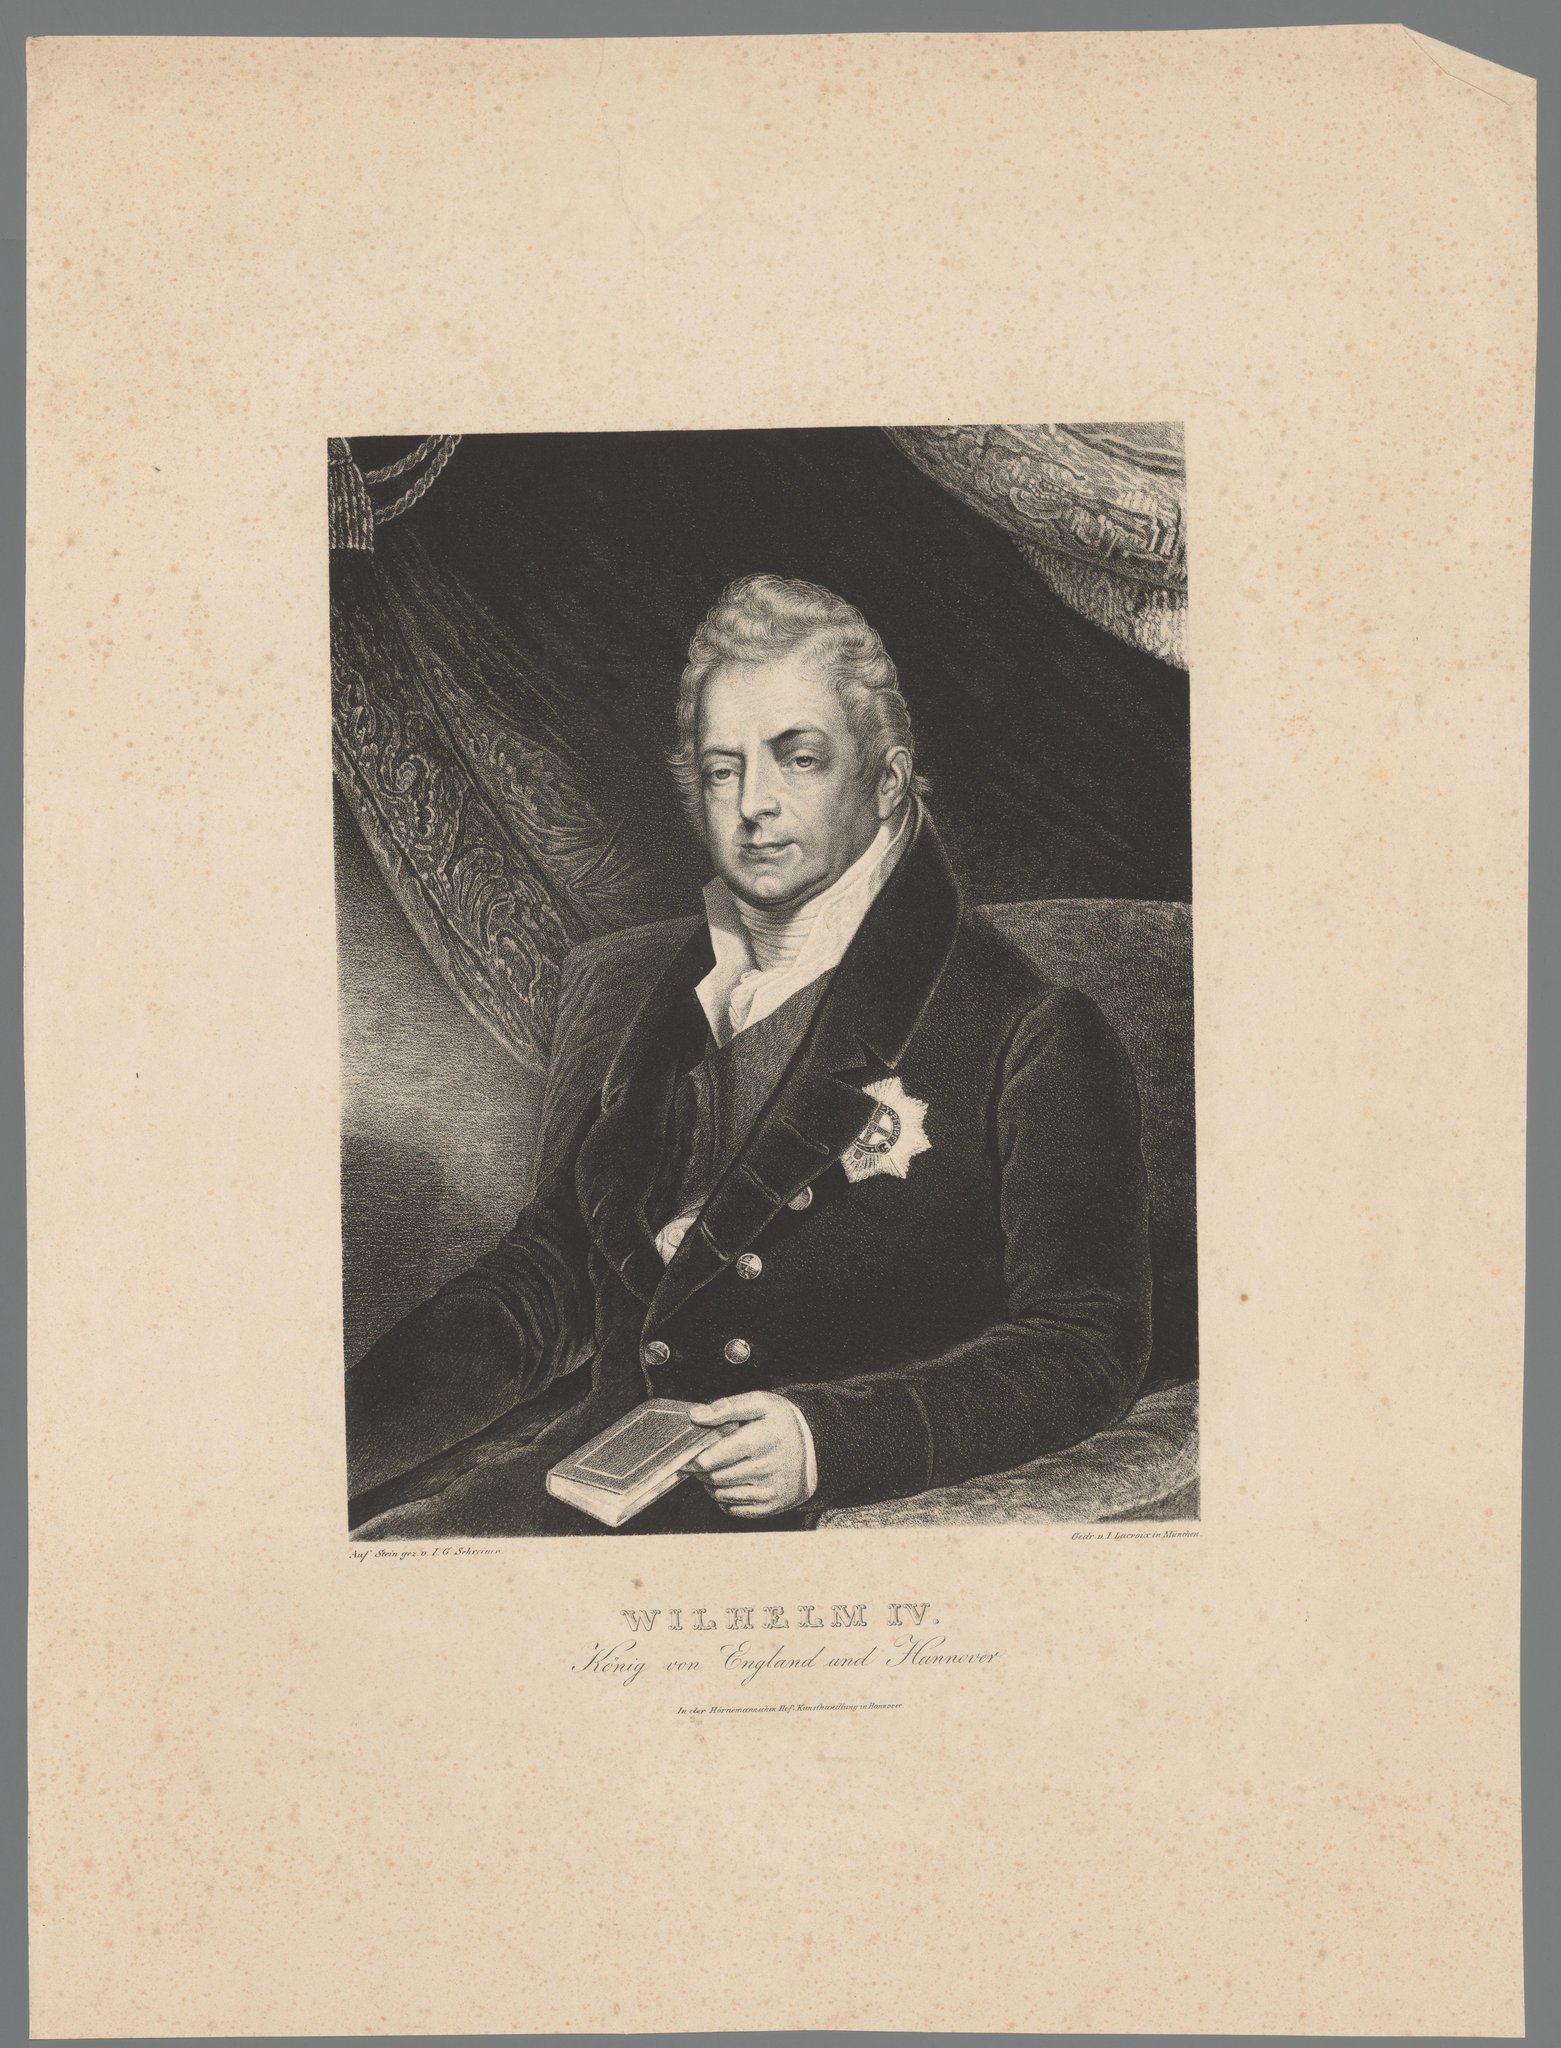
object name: print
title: Portret van Willem IV Hendrik (koning van het Verenigd Koninkrijk en Hannover)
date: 1811-1859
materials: paper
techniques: lithograph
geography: hannover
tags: london, willem iv hendrik (koning van het verenigd koninkrijk en hannover), historical persons, king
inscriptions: collector's mark: Lugt 2228